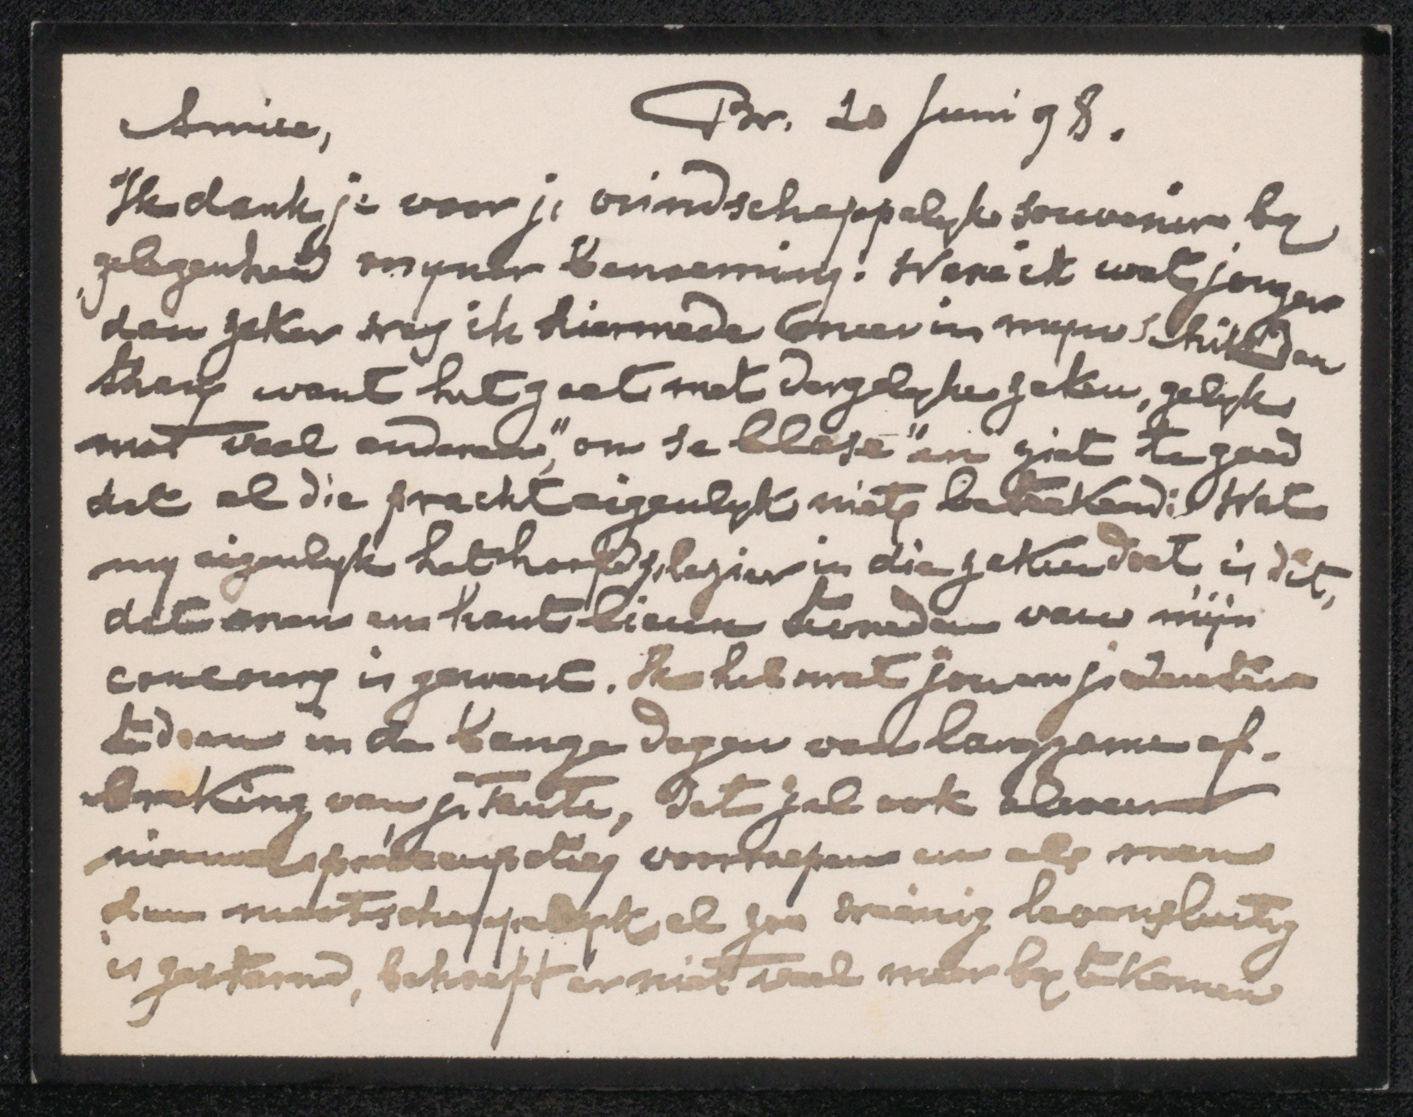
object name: letter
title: Brief aan August Allebé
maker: johannes hubertus leonardus de haas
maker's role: draughtsman, painter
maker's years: 1832-1908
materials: cardboard, ink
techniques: pen, writing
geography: brussels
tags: print maker, august allebé